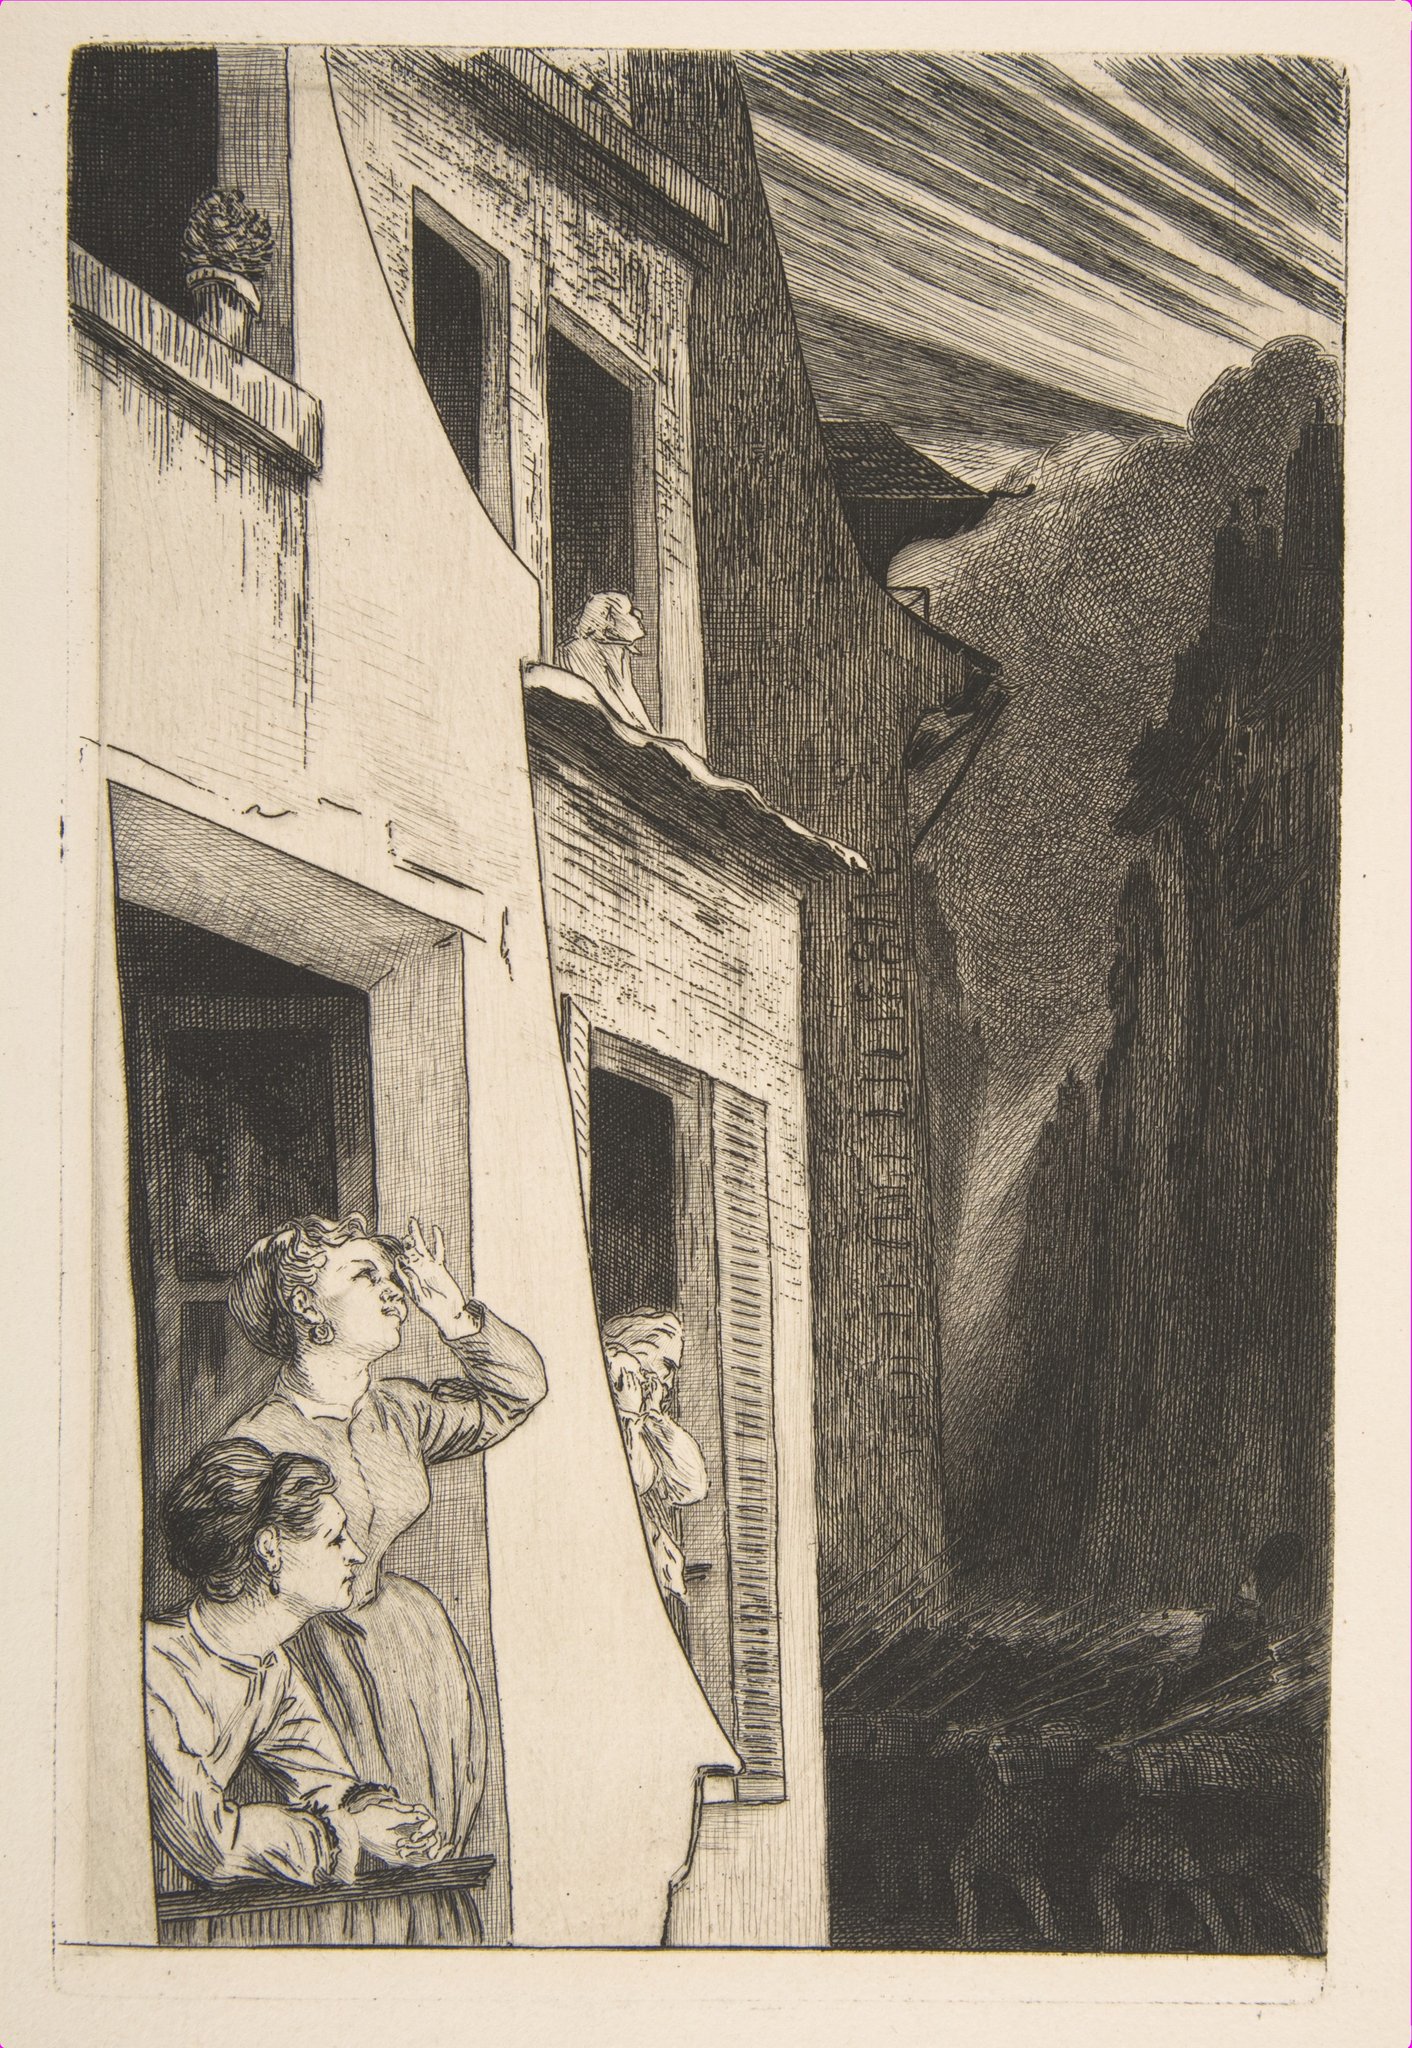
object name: print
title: L'Eclipse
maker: félix bracquemond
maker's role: artist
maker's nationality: french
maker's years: 1833-1914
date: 1869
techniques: etching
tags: windows,women